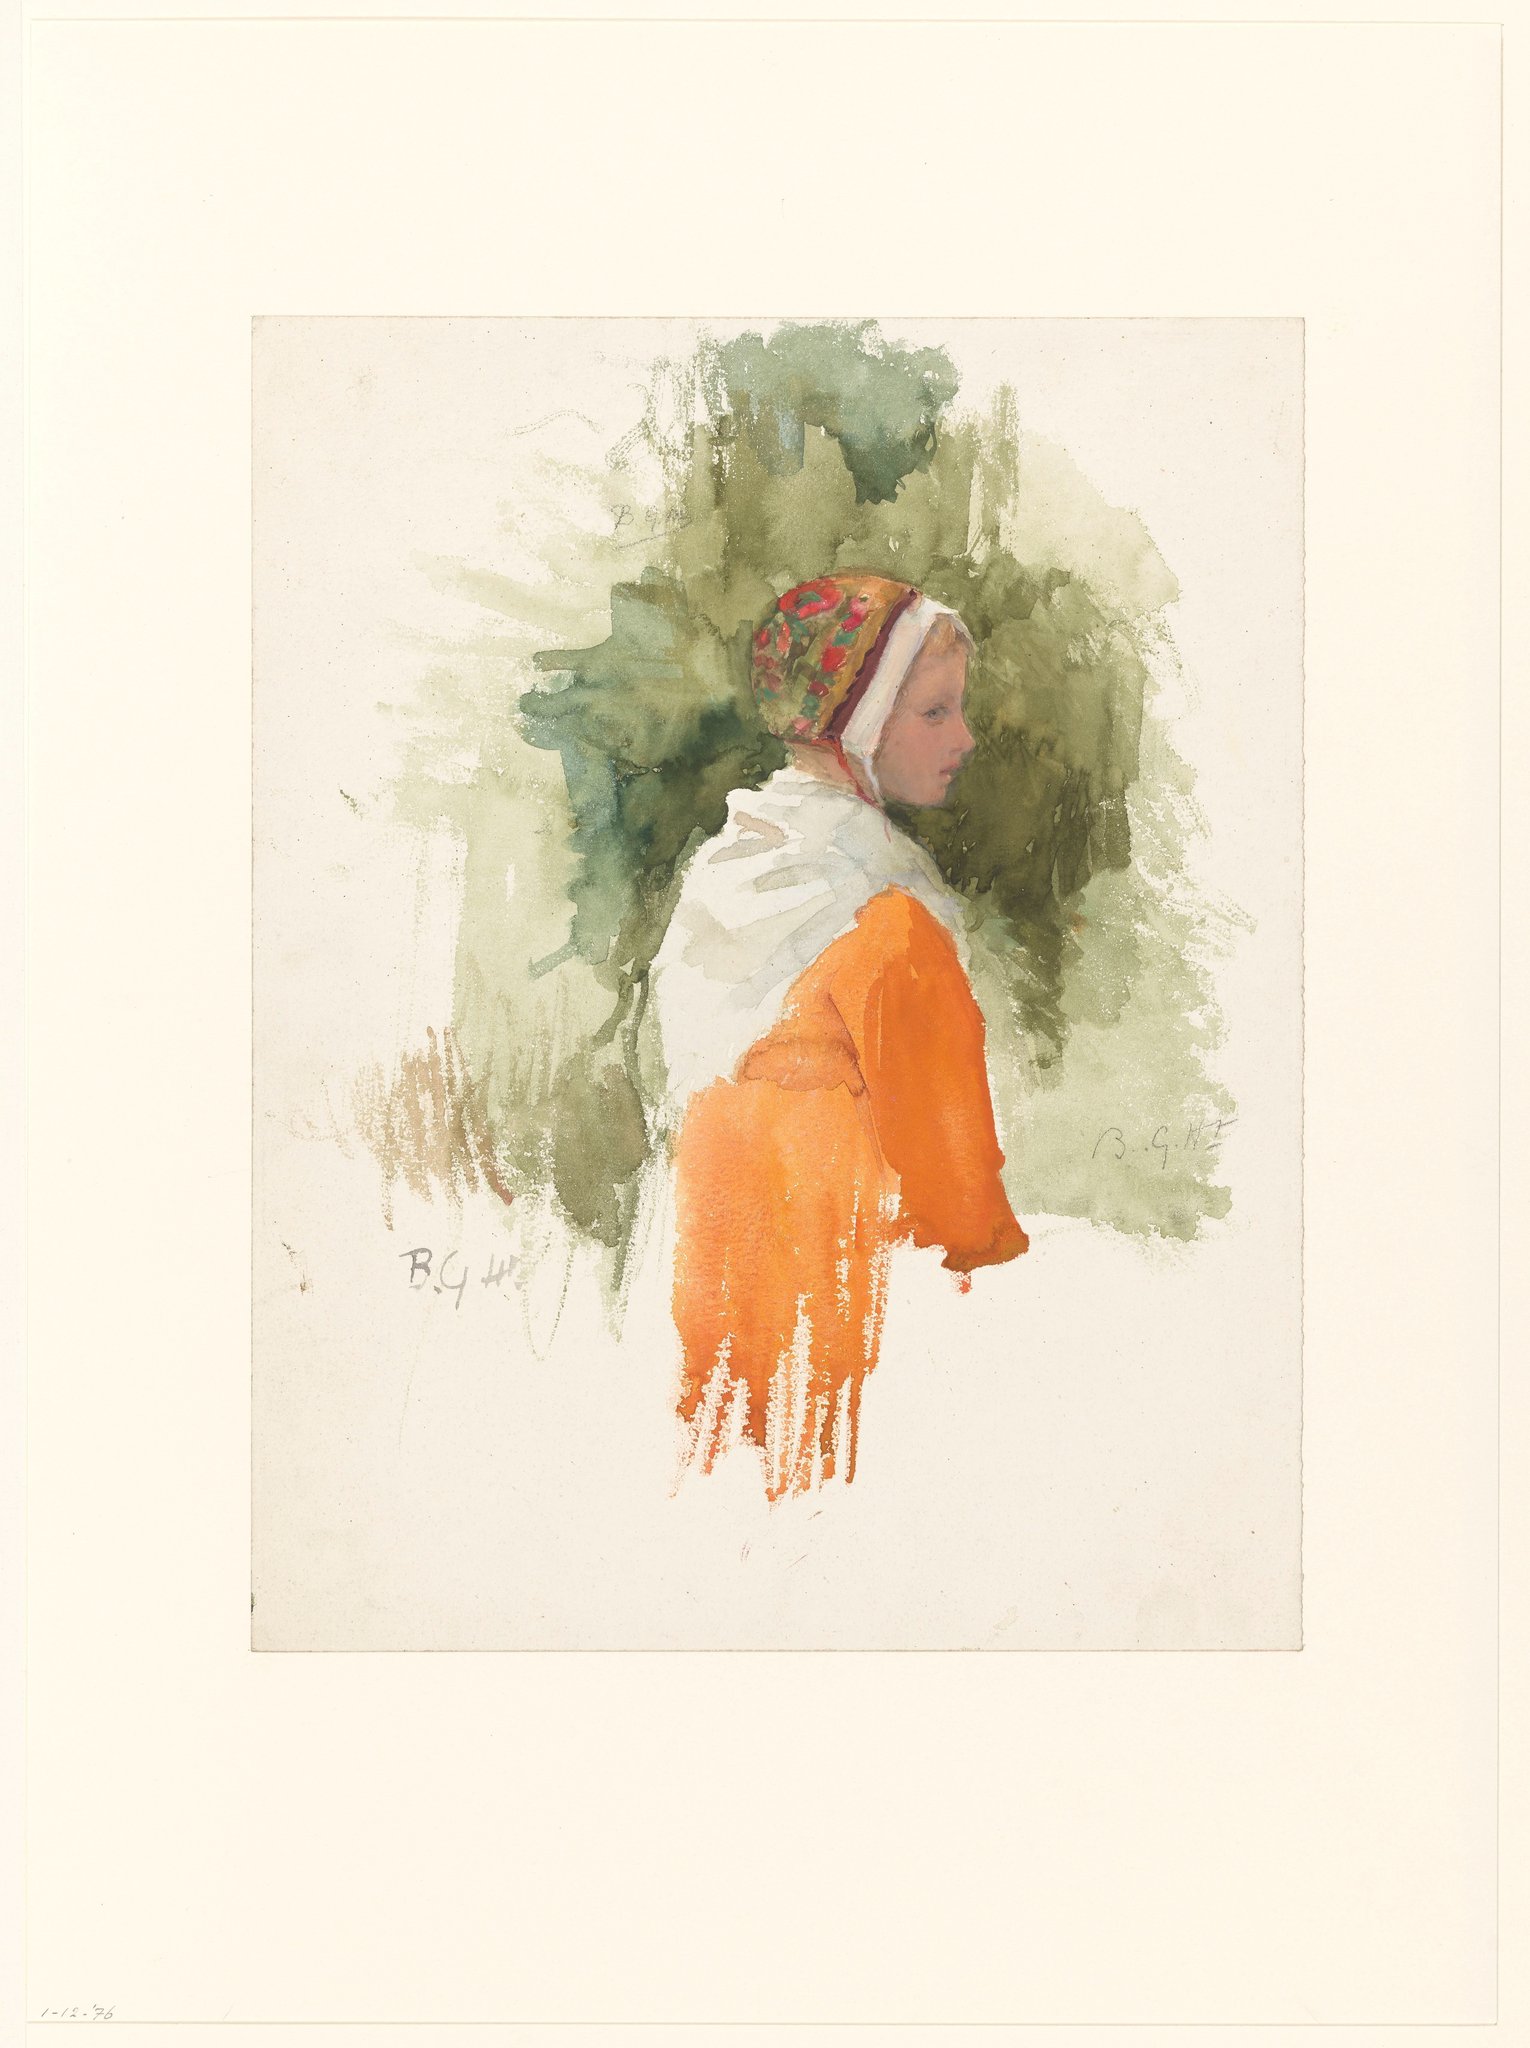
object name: watercolor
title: Girl Wearing a Cap and an Orange Dress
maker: a.a.l. de grammont-hubrecht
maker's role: draughtsman, painter, print maker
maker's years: 1855-1913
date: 1865-1913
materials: paper, watercolor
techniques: brush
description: A successful portraitist and an exceptionally prolific draughtsman, Bramine Hubrecht participated in exhibitions in Europe and America. The artist excelled particularly as a watercolourist. This colourful sketch evidences her highly expressive way of painting. Hubrecht visibly enjoyed the play of colours. She signed the work no less than three times, with hermarried name: Grandmont-Hubrecht.